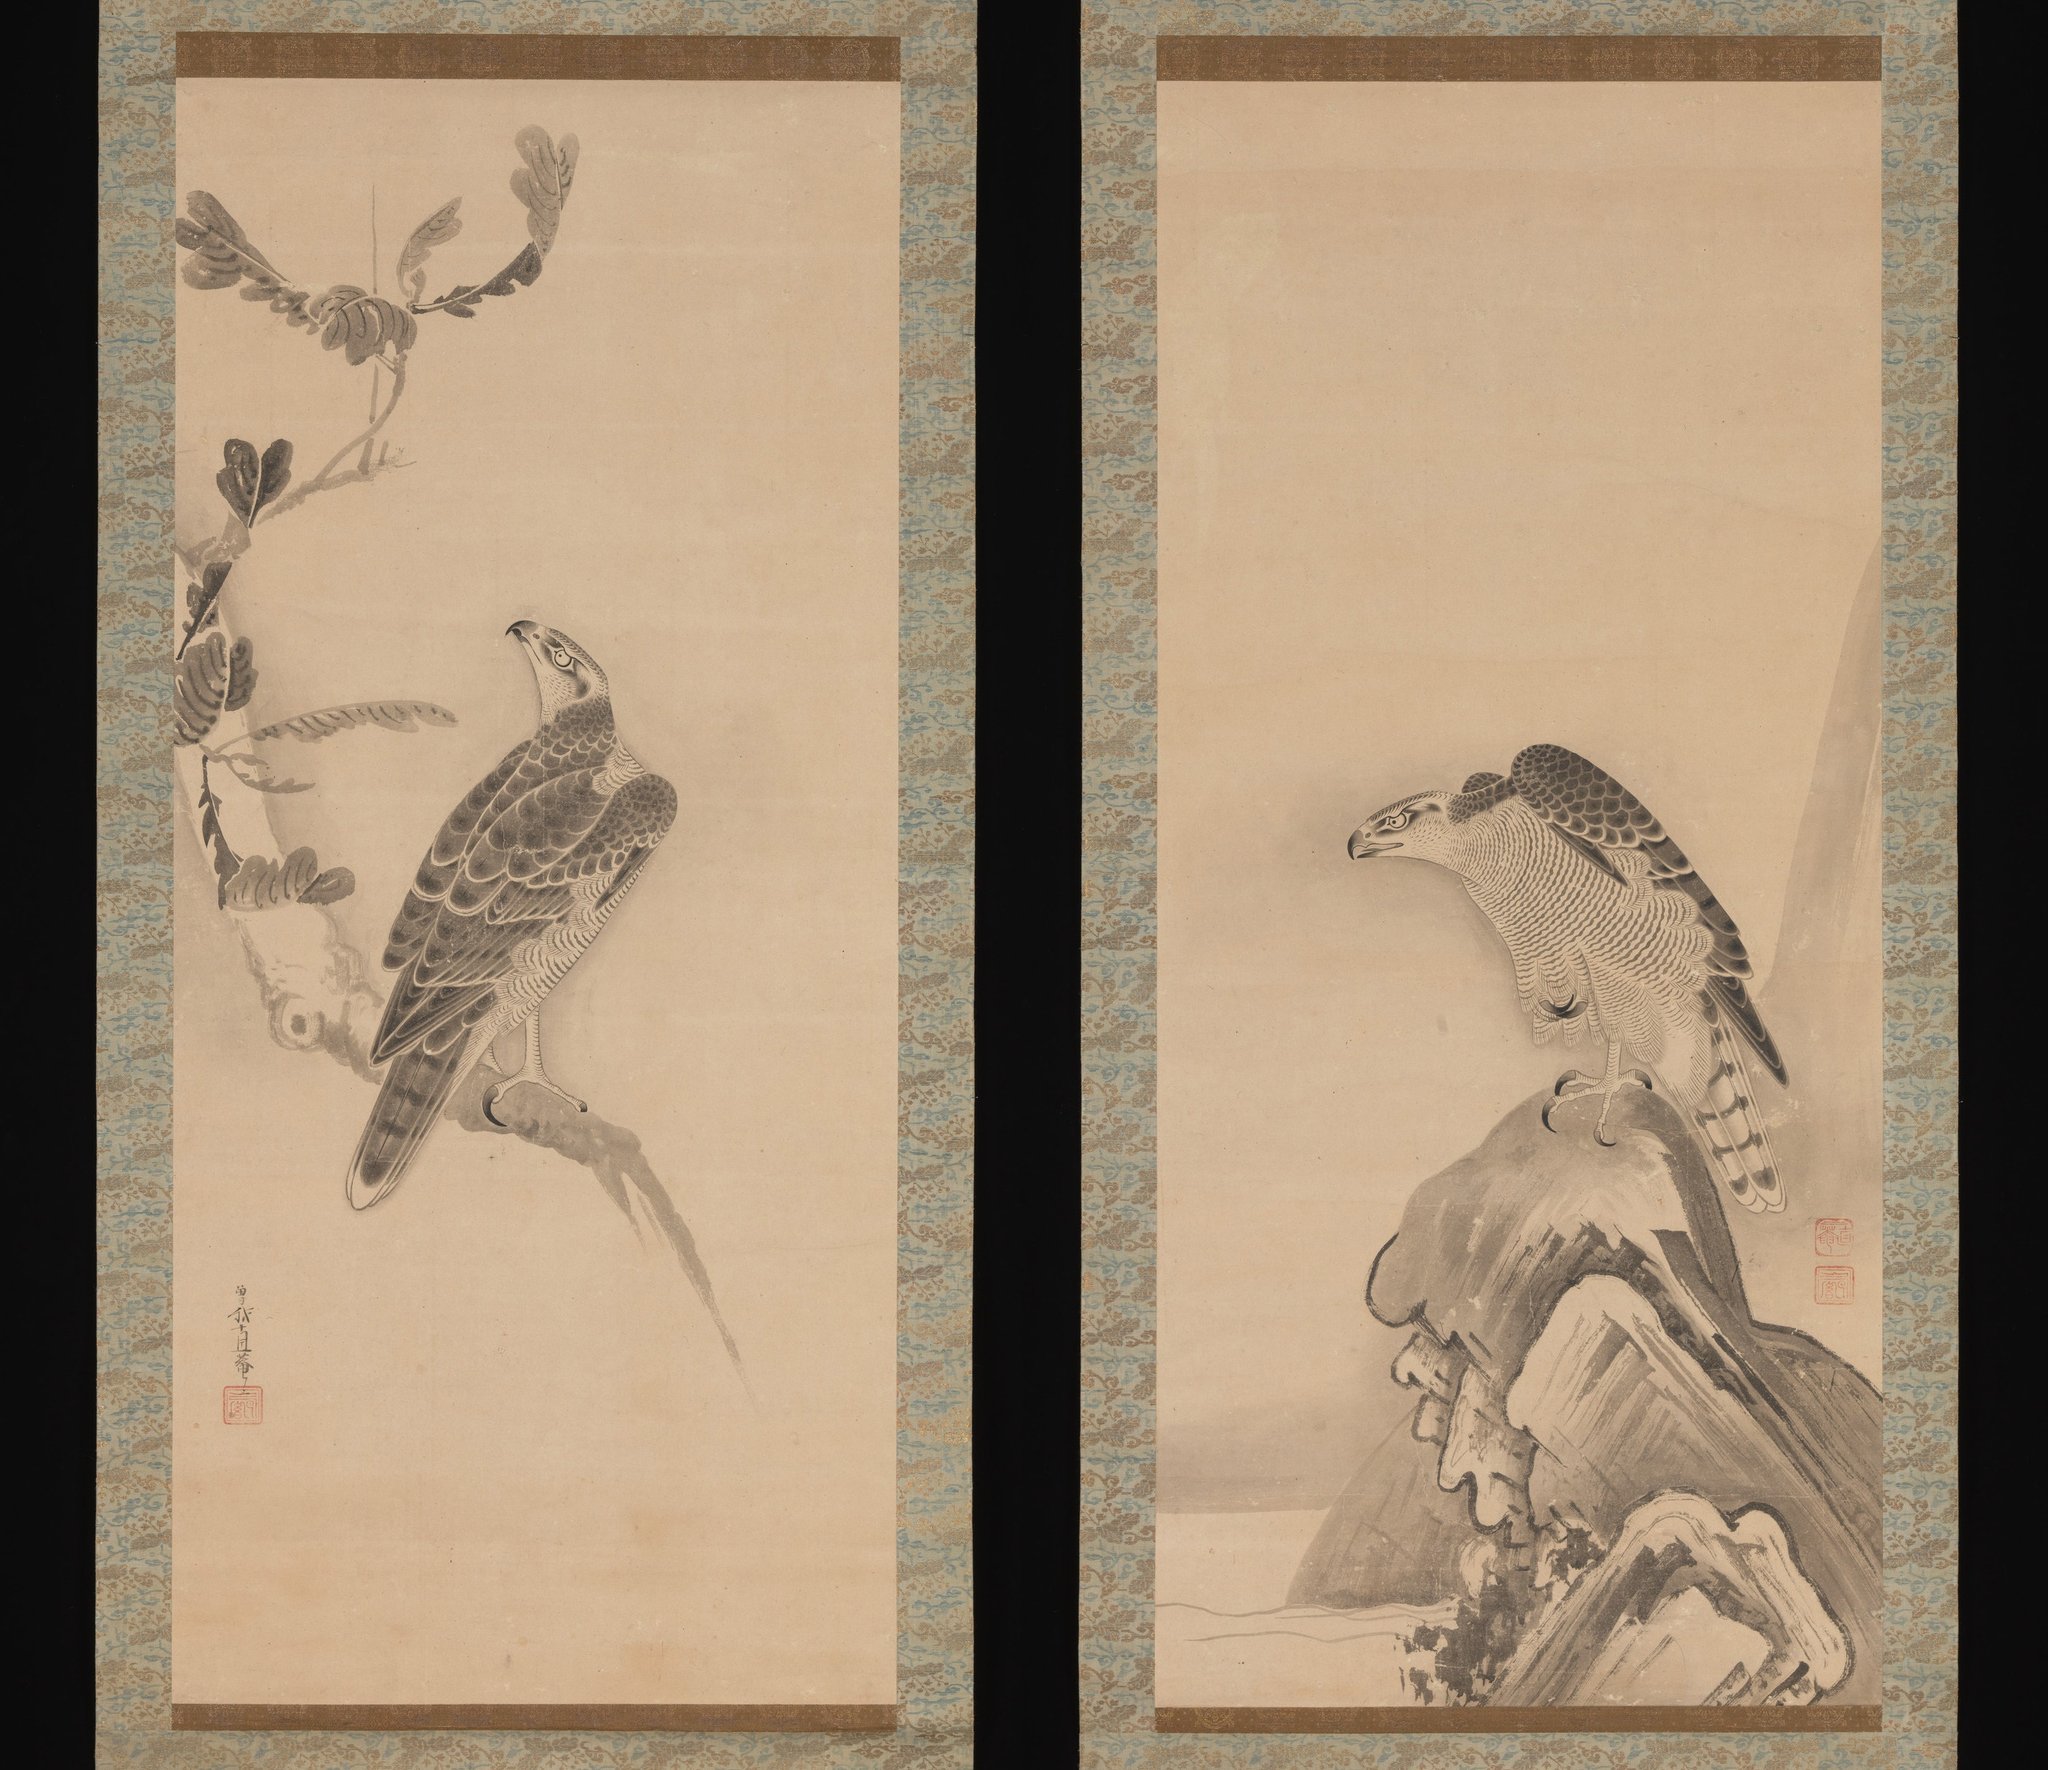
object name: hanging scroll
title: Hawks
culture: japanese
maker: soga nichokuan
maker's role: artist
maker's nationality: japanese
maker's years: 1600-1700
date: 1634-1666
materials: ink, paper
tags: hawks